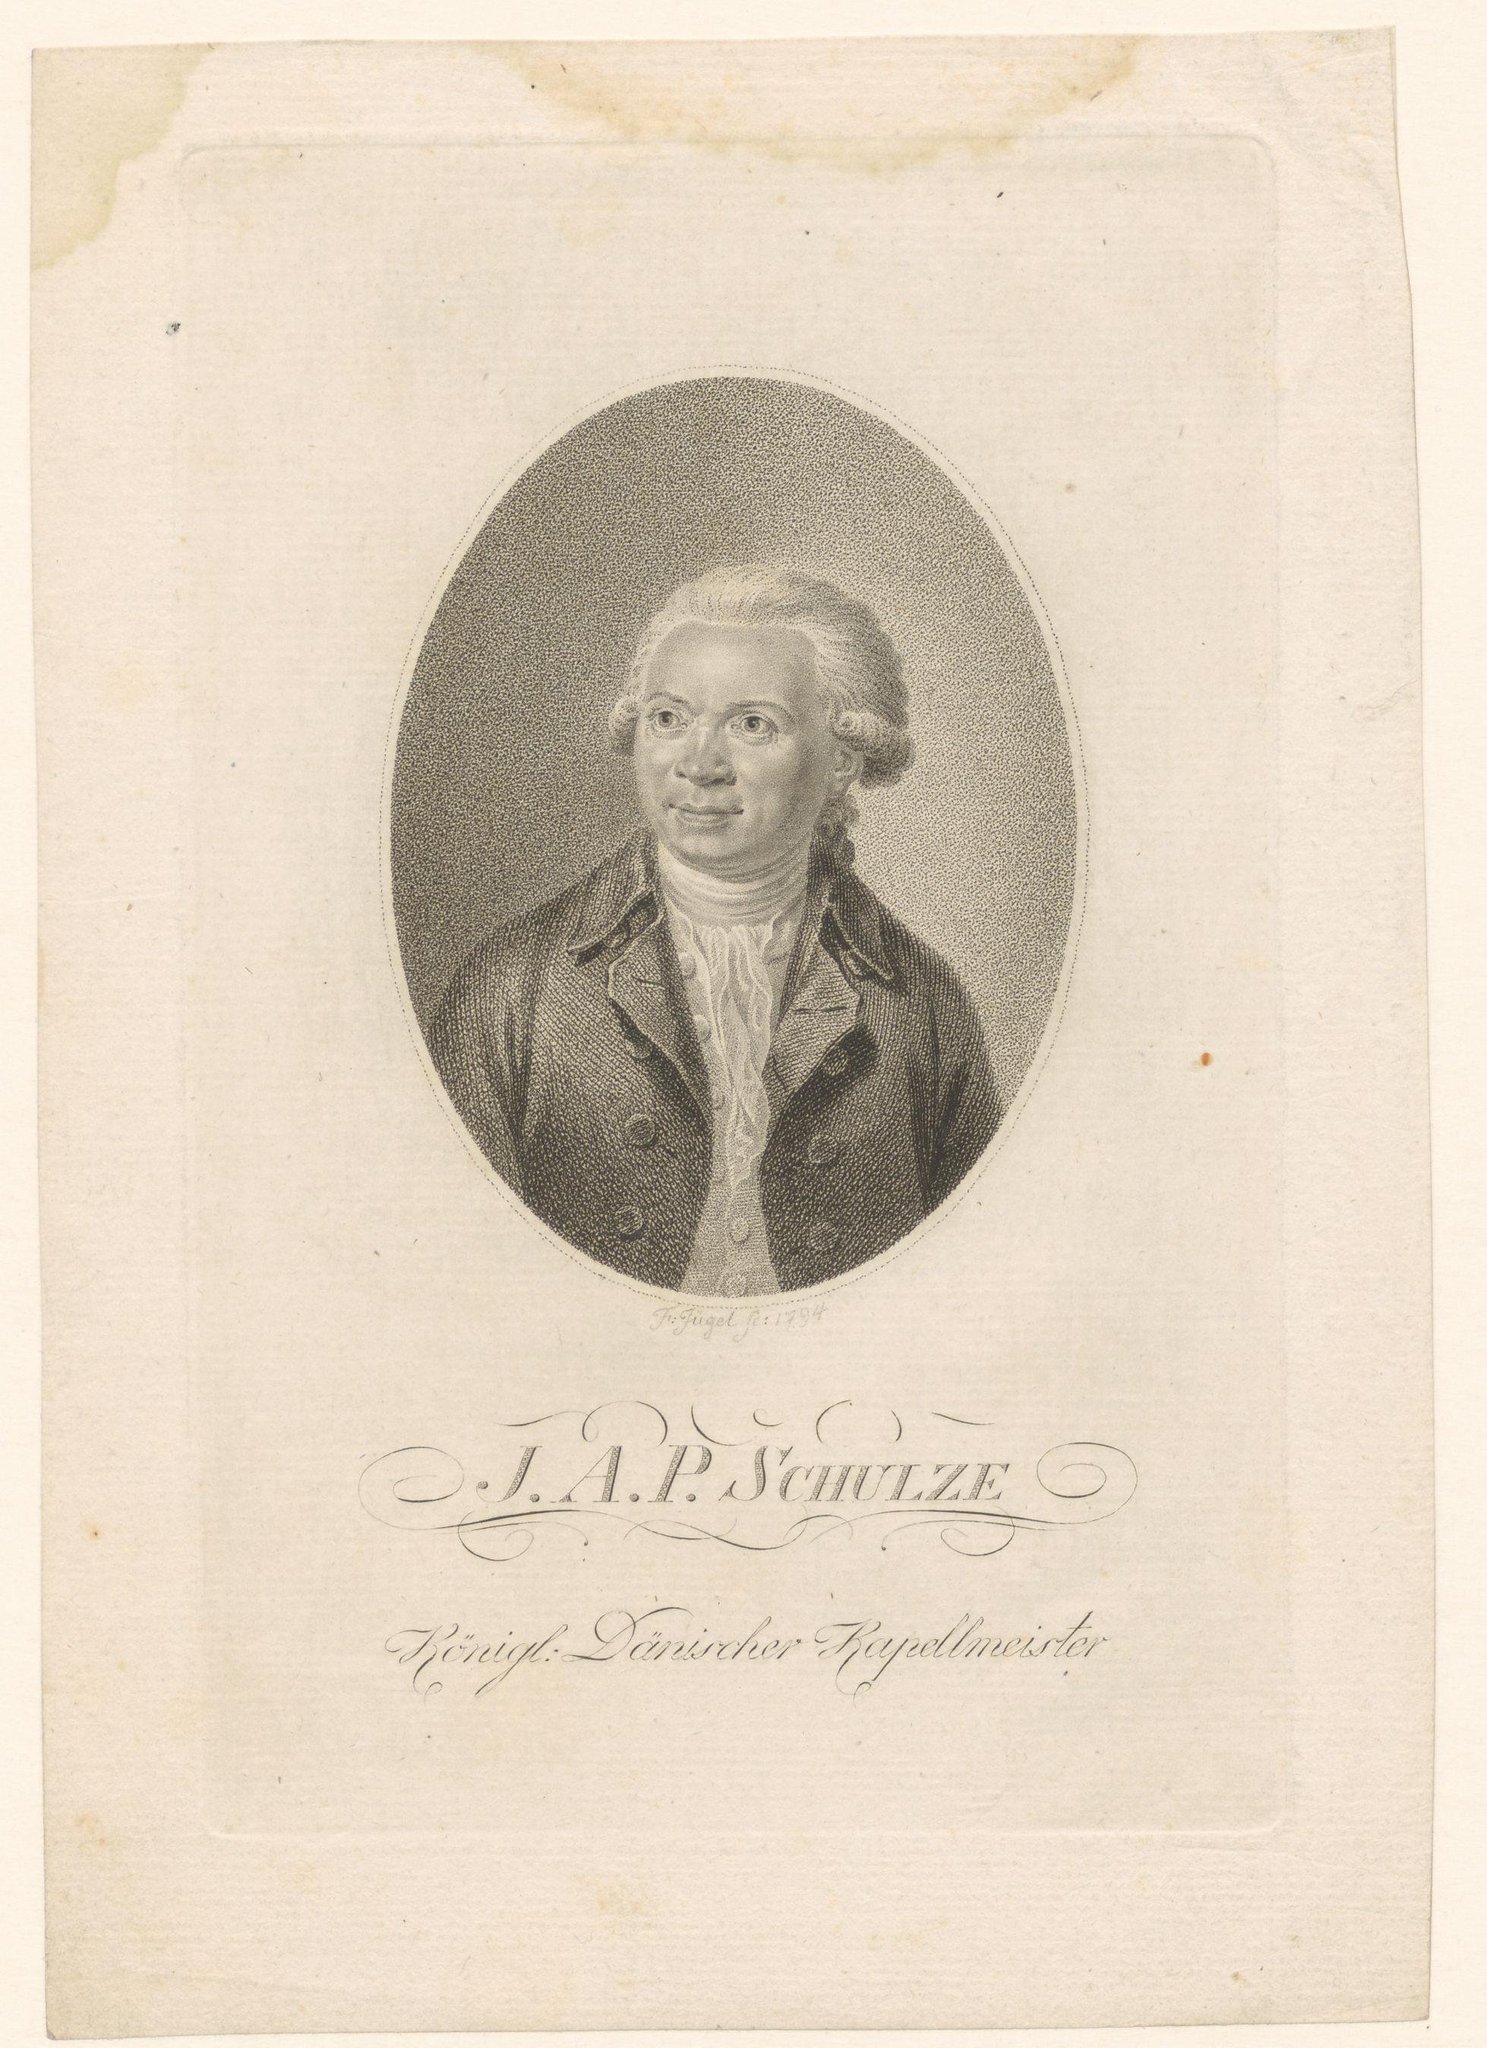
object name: print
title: Portret van Johan Abraham Peter Schulz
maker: friedrich jügel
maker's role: print maker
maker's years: 1772-1833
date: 1794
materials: paper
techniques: stippling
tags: historical persons, portrait of composer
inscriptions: collector's mark: Lugt 2228